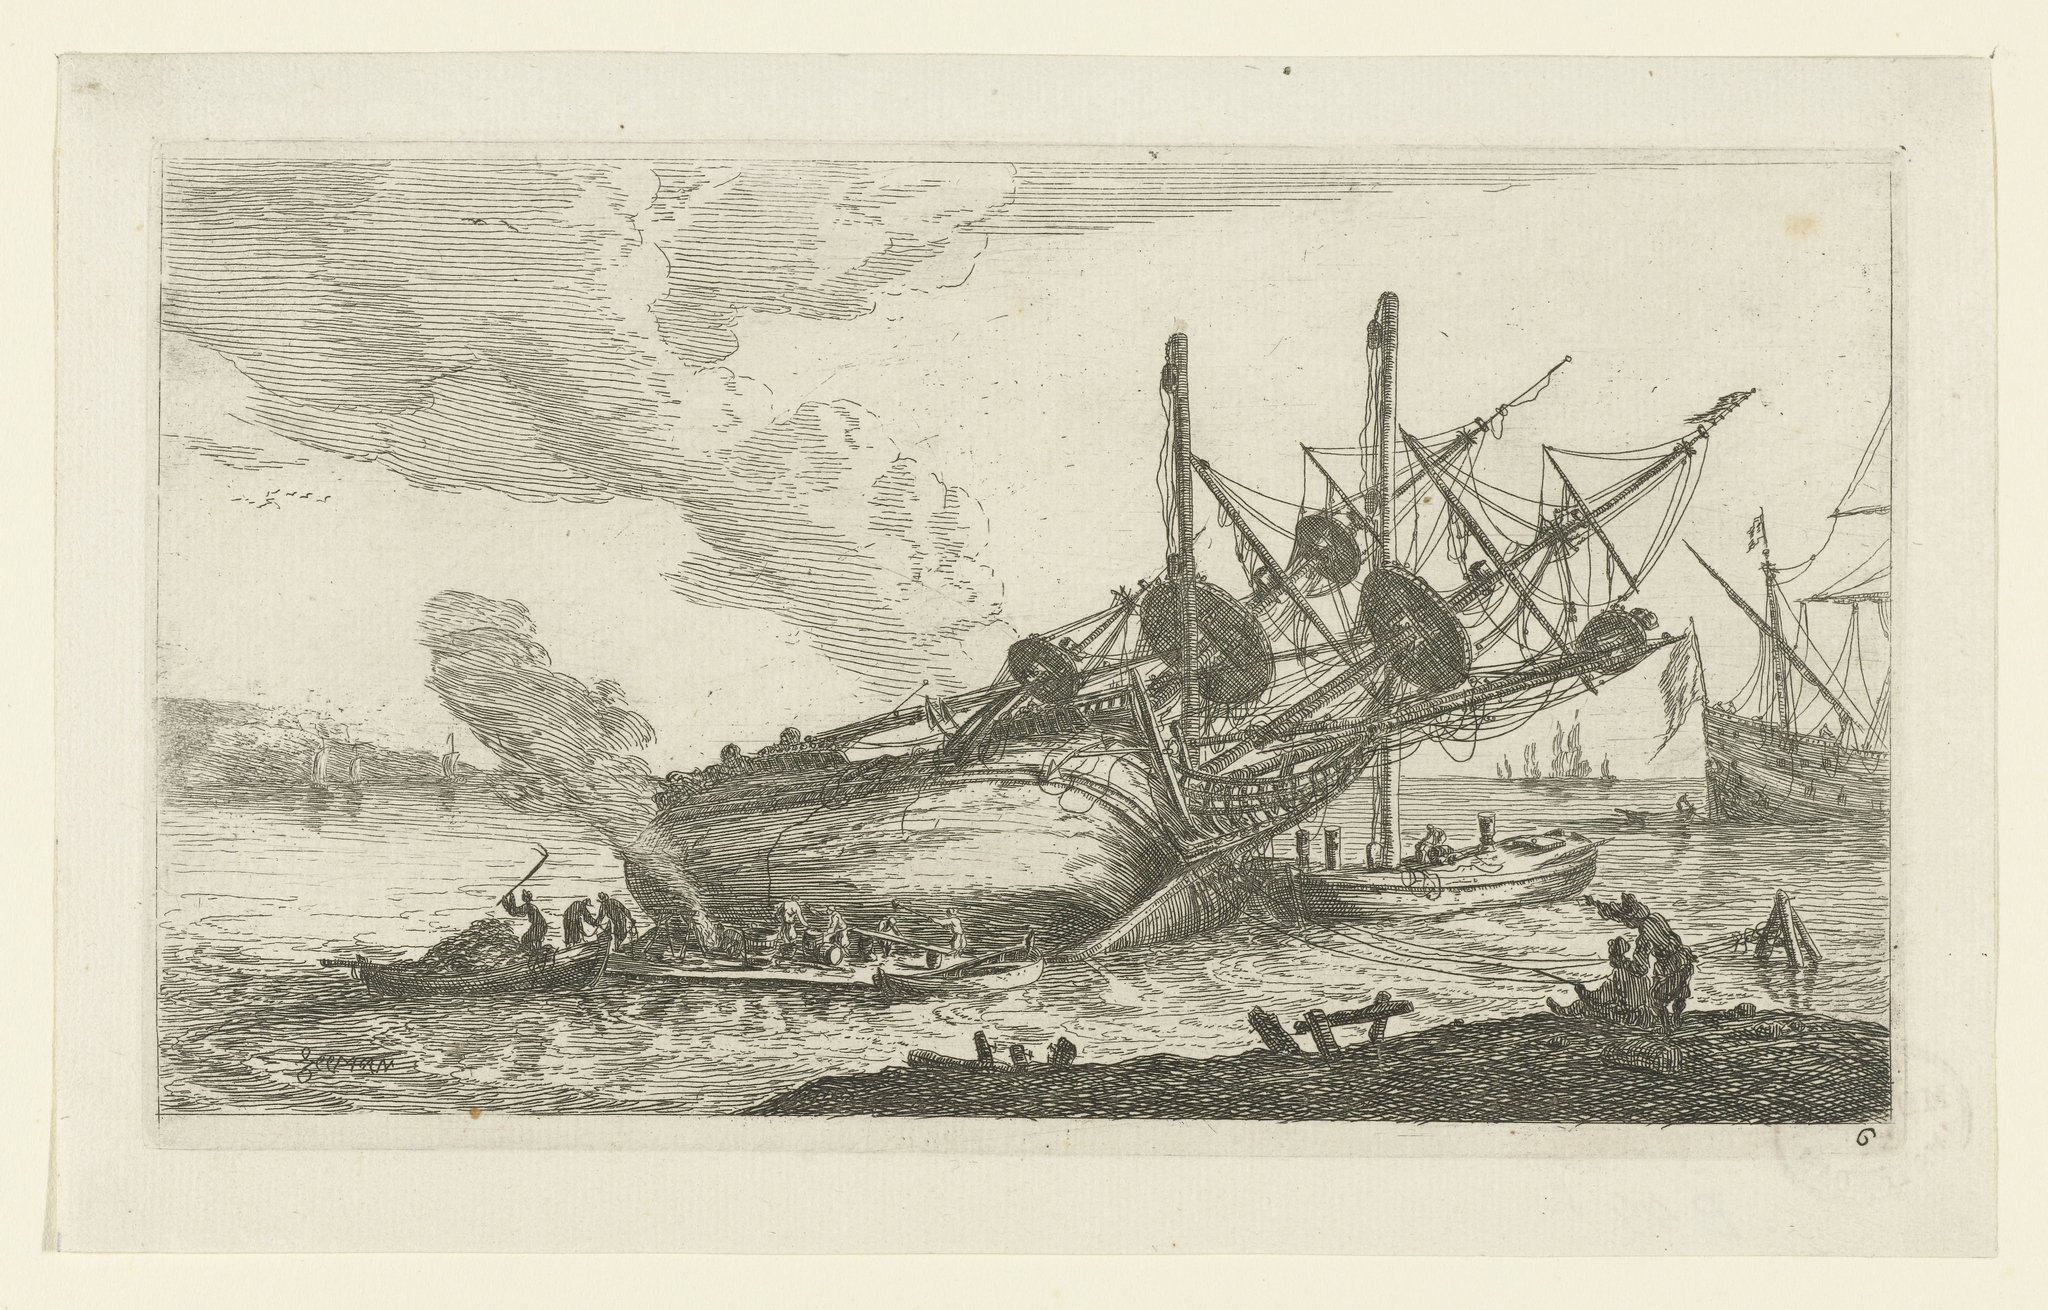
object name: print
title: Enkele zeilschepen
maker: reinier nooms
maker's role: draughtsman, painter, print maker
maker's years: 1623-1664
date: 1652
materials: paper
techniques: etching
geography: netherlands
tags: repairing, caulking, careening (~ ship)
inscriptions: collector's mark: Lugt 12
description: Een groot schip wordt gekield met behulp van een onderlegger. Op een vlot staan mannen die reperaties verrichten aan het schip en de romp waterdicht maken.